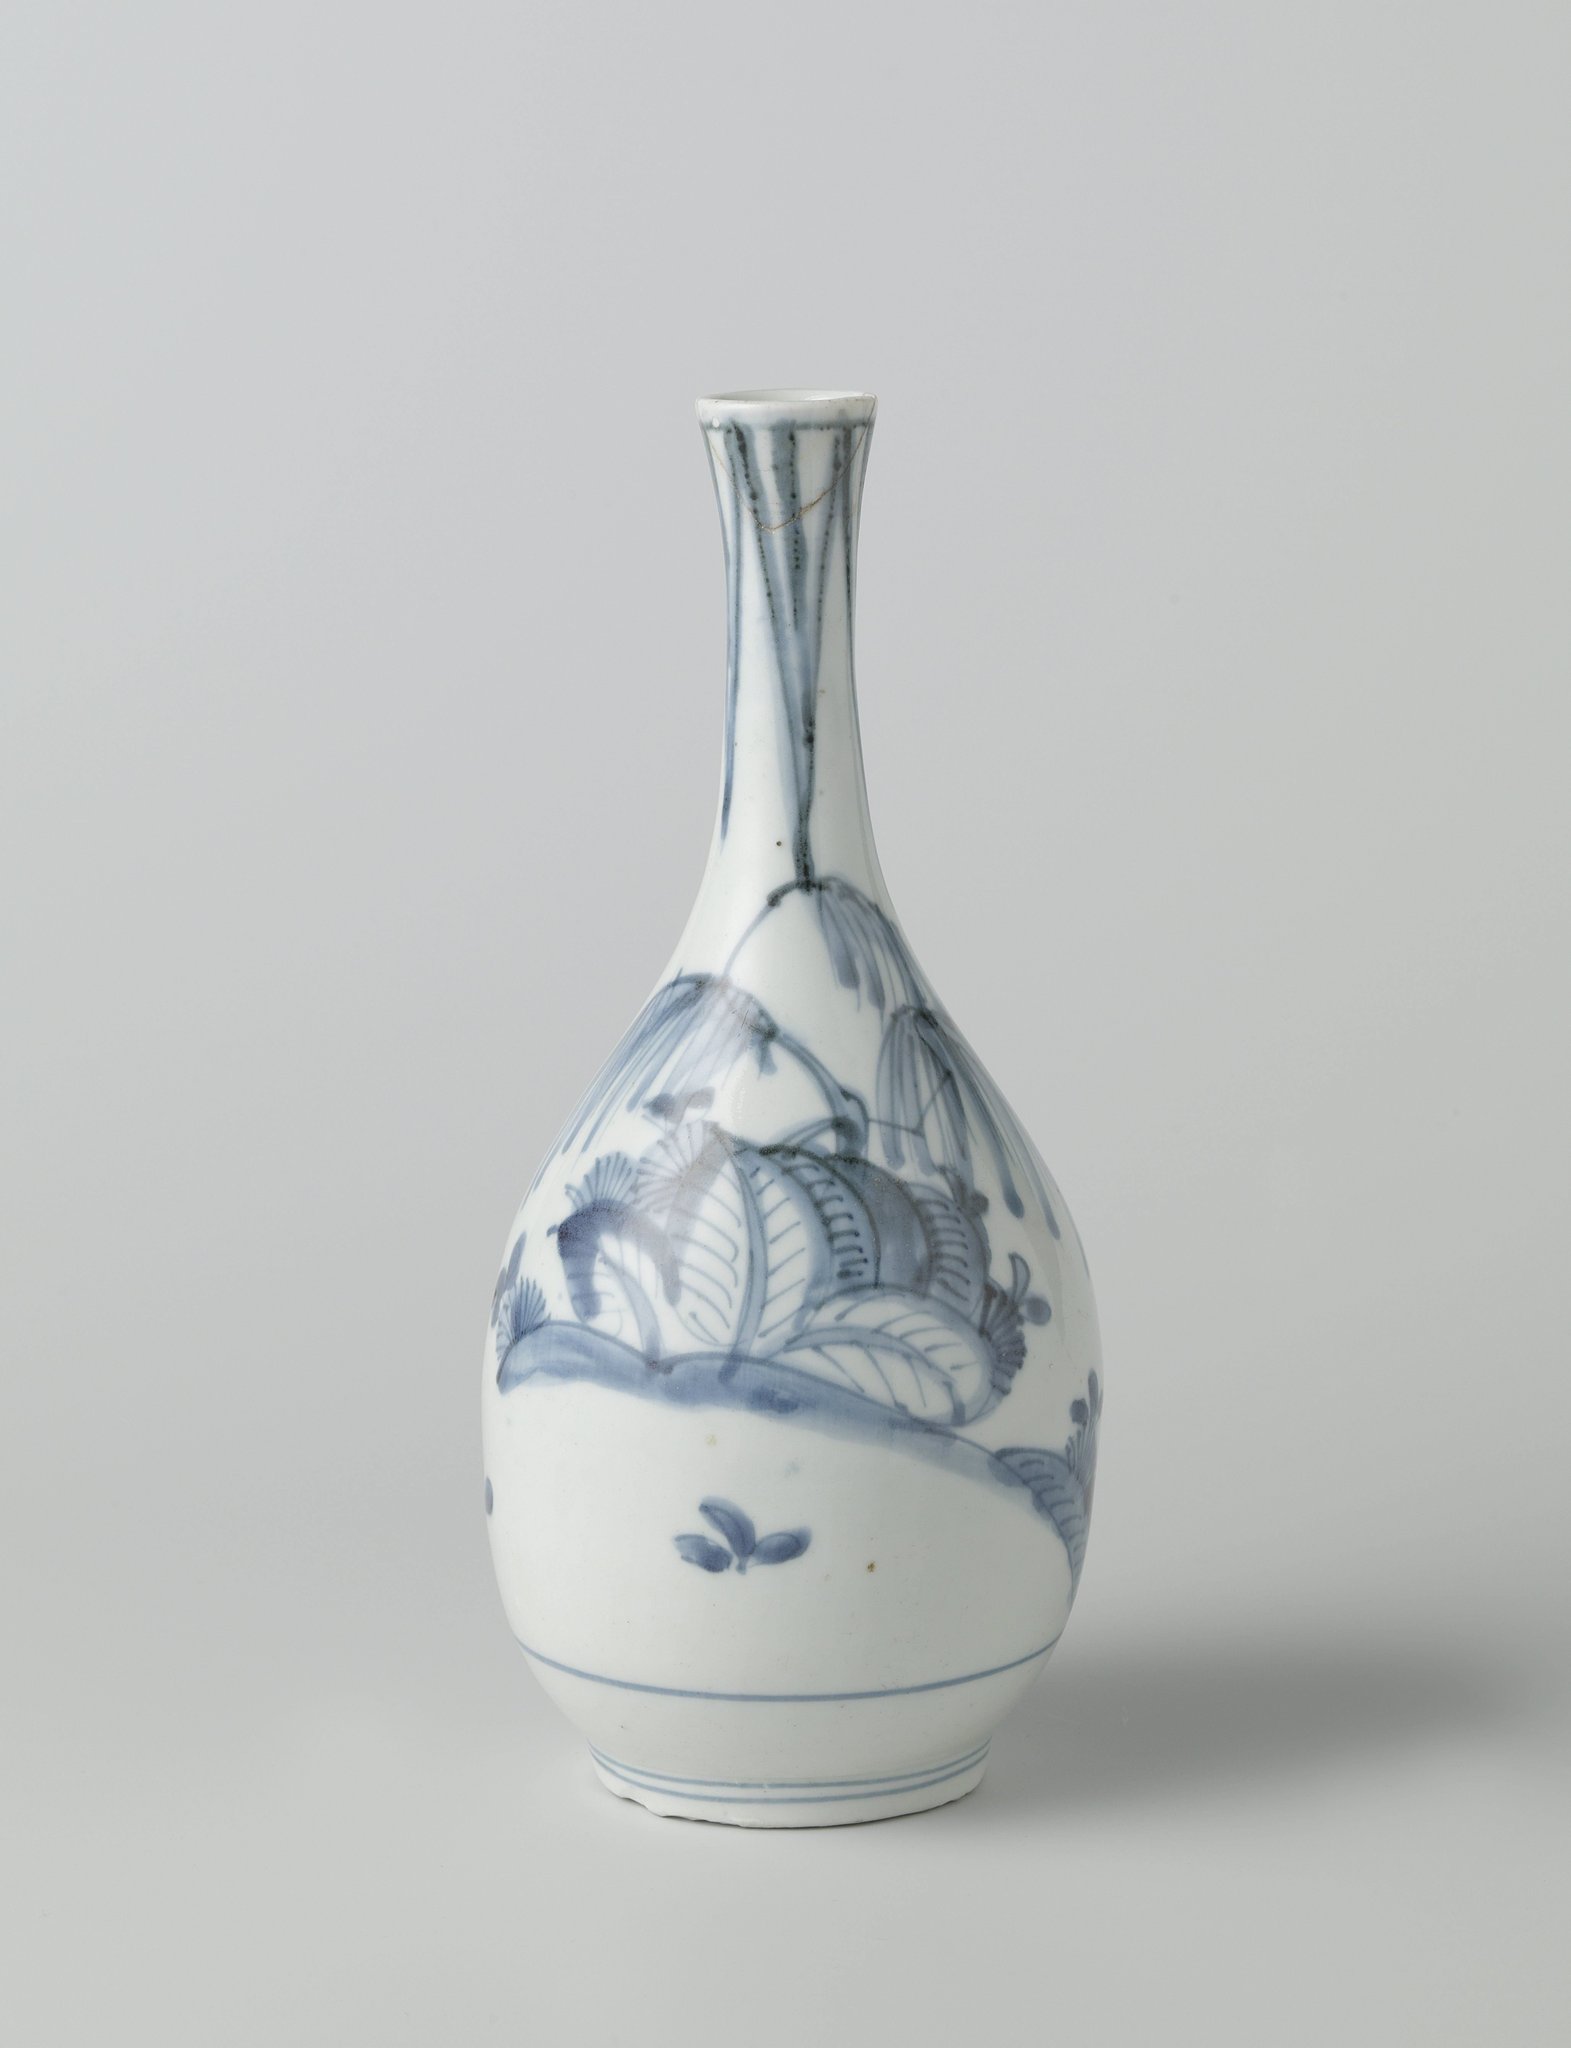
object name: bottle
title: Rosewater bottle with flowering plats and a petal border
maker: Anonymous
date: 1650-1670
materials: cobalt, glaze, paint, porcelain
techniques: firing, turning, vitrification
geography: japan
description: Rozenwaterfles van porselein met peervormig lichaan en smalle, iets uitlopende nek, beschilderd in onderglazuur blauw. Op de wand planten met grote bladeren en een boom. Op de nek afhangende, puntige bladmotieven vanuit de rand. Rand is gebroken geweest. Voetring gechipt. Arita, blauw-wit.